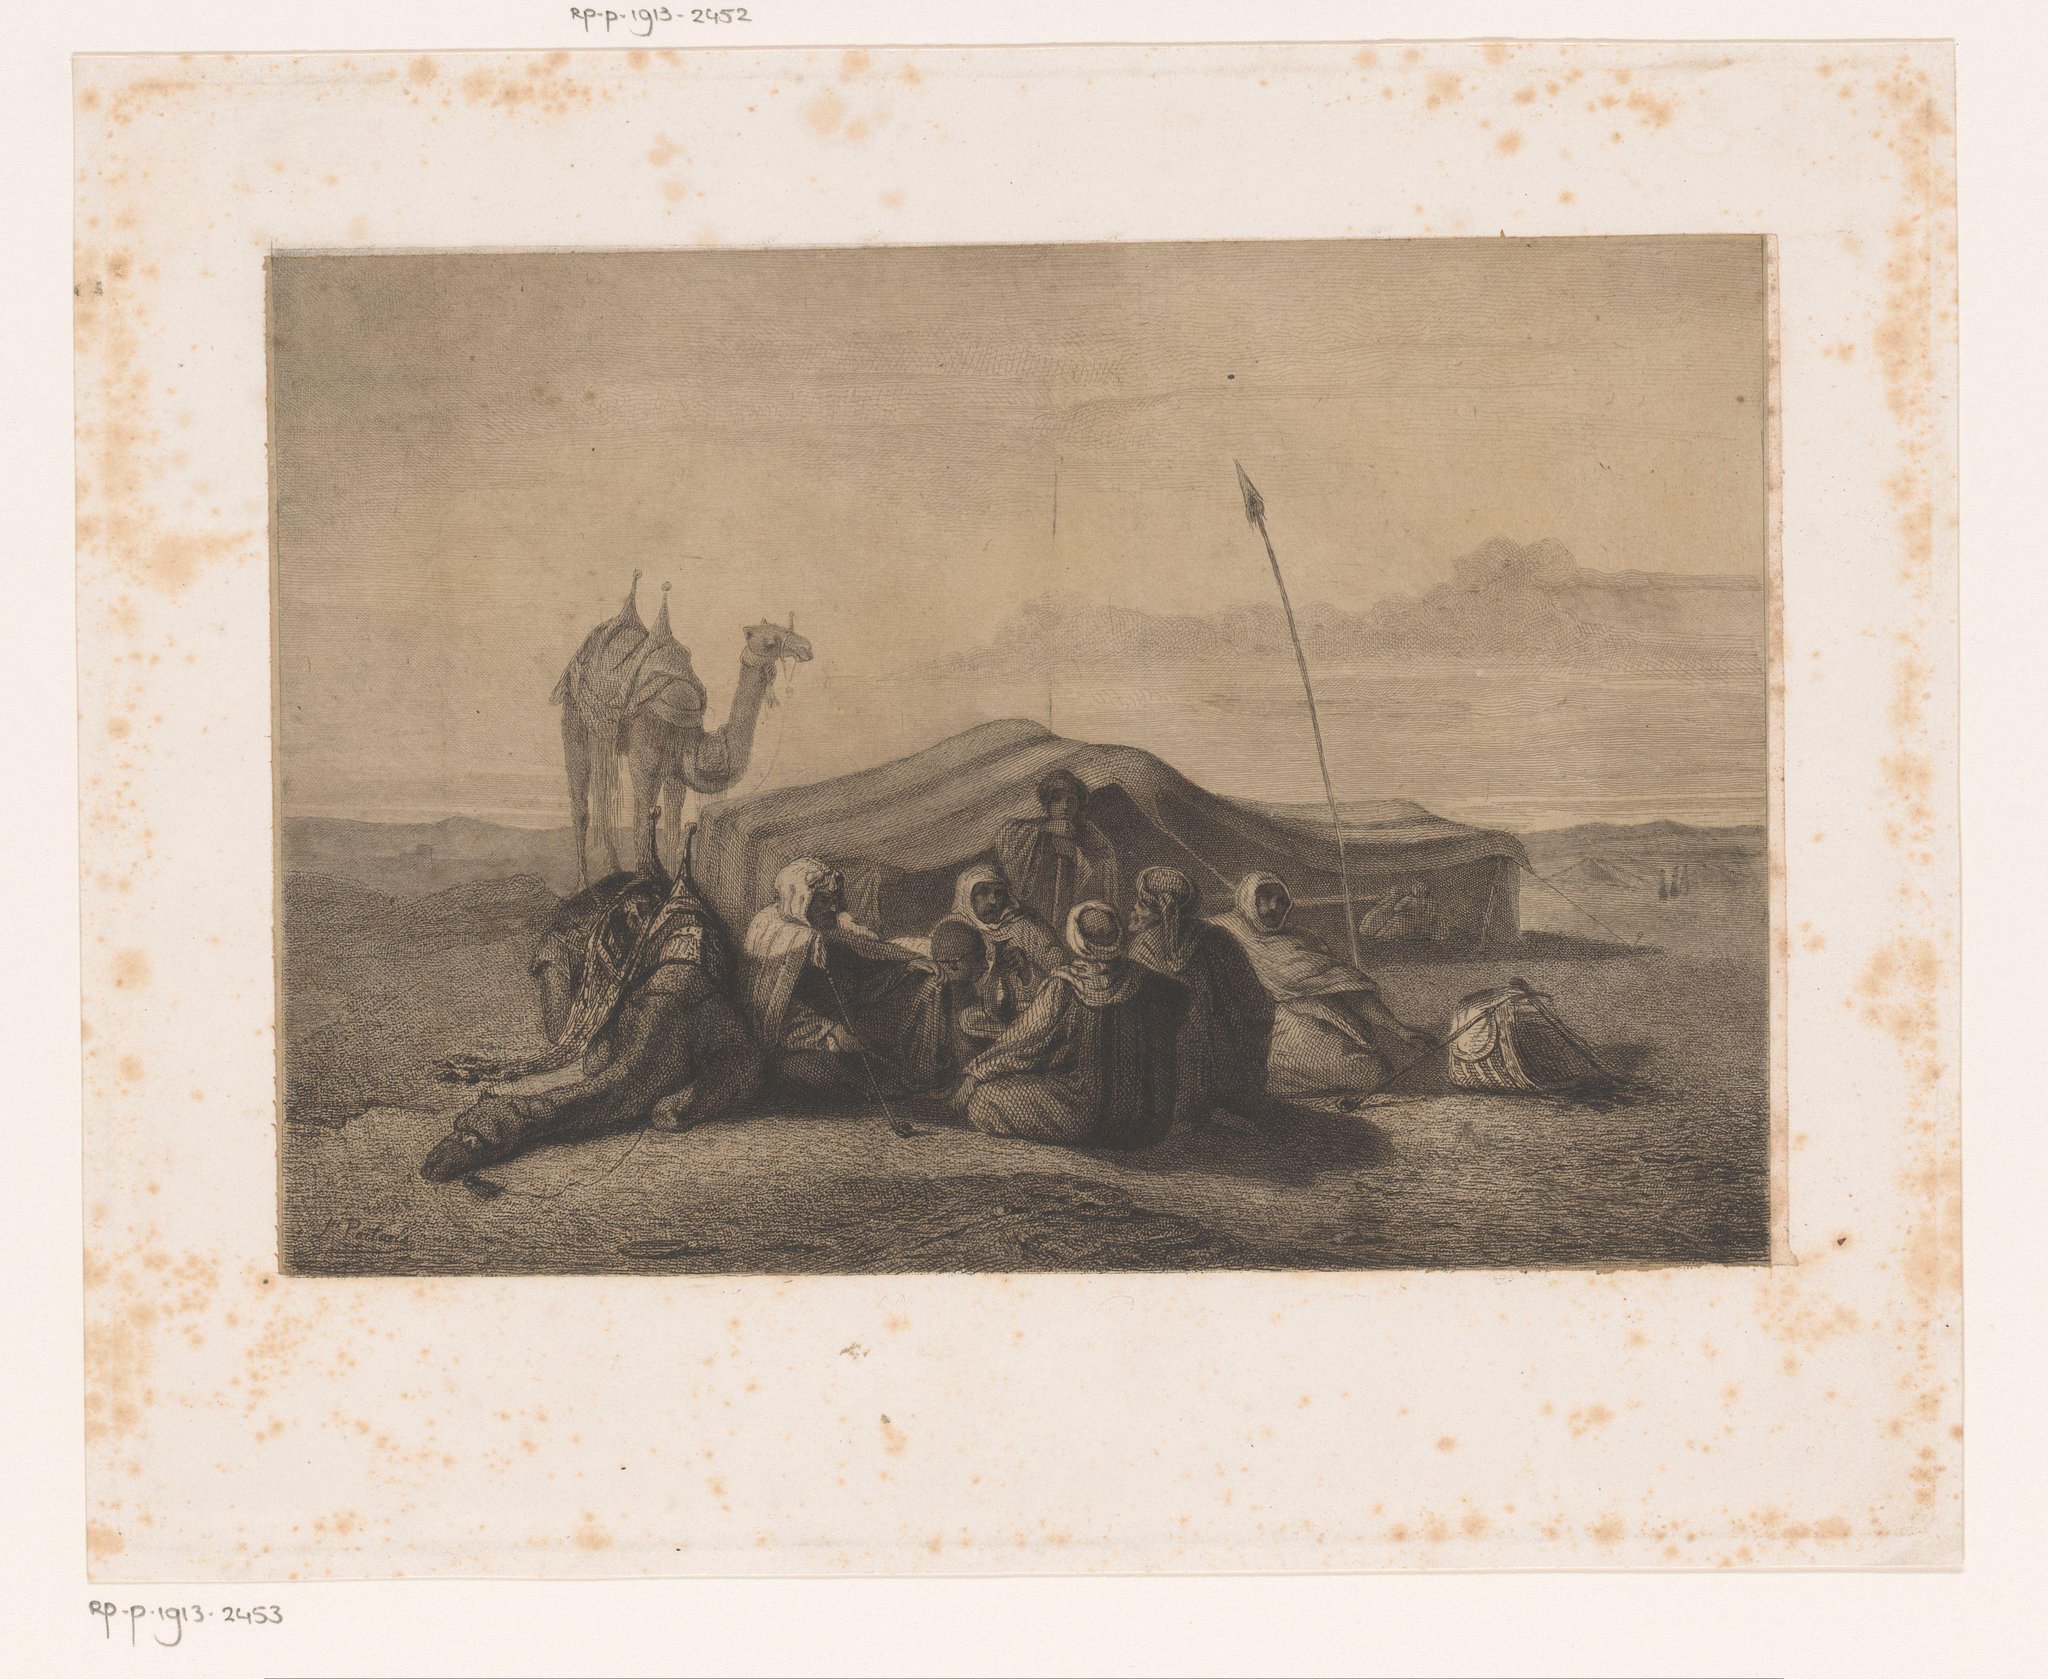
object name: print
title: Groep rustende reizigers in de woestijn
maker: jean françois portaels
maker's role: print maker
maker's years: 1818-1895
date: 1828-1895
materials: paper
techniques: drypoint, etching, roulette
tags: hoofed animals: camel, oasis, wandering communities living in tents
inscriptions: collector's mark: Lugt 1485, collector's mark: Lugt 2228